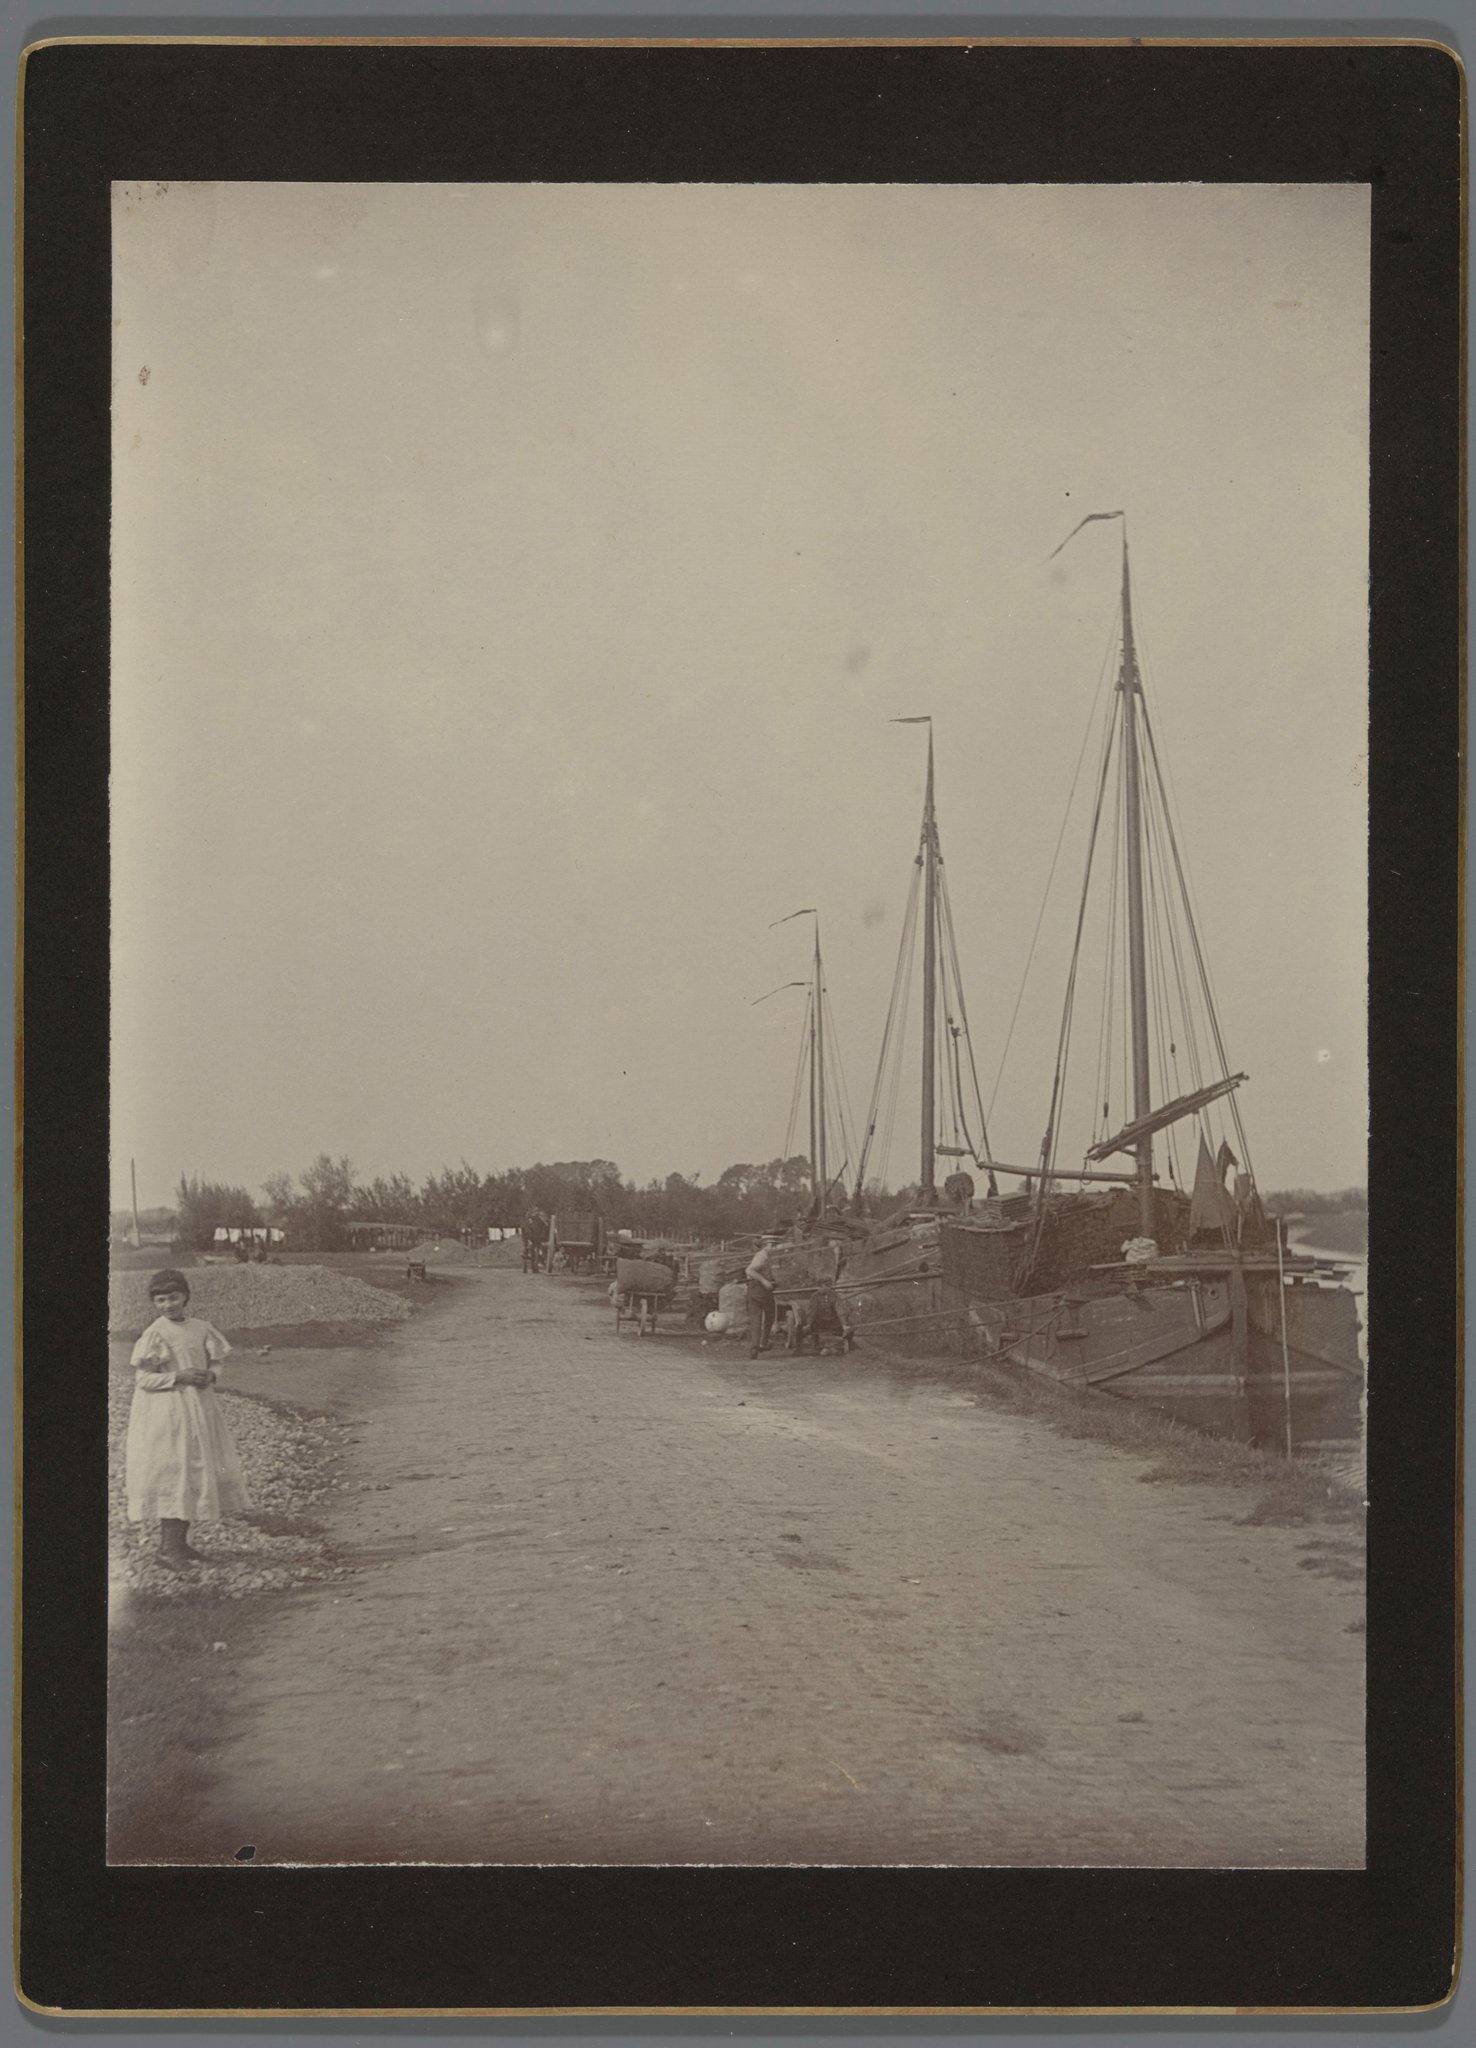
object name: photograph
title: Kade met drie boten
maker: cornelia hendrika jonker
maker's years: 1874-1924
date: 1880-1940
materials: cardboard, photographic support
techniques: collodion silver print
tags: ships (in general), quay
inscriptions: annotation: ‘Hattem?’